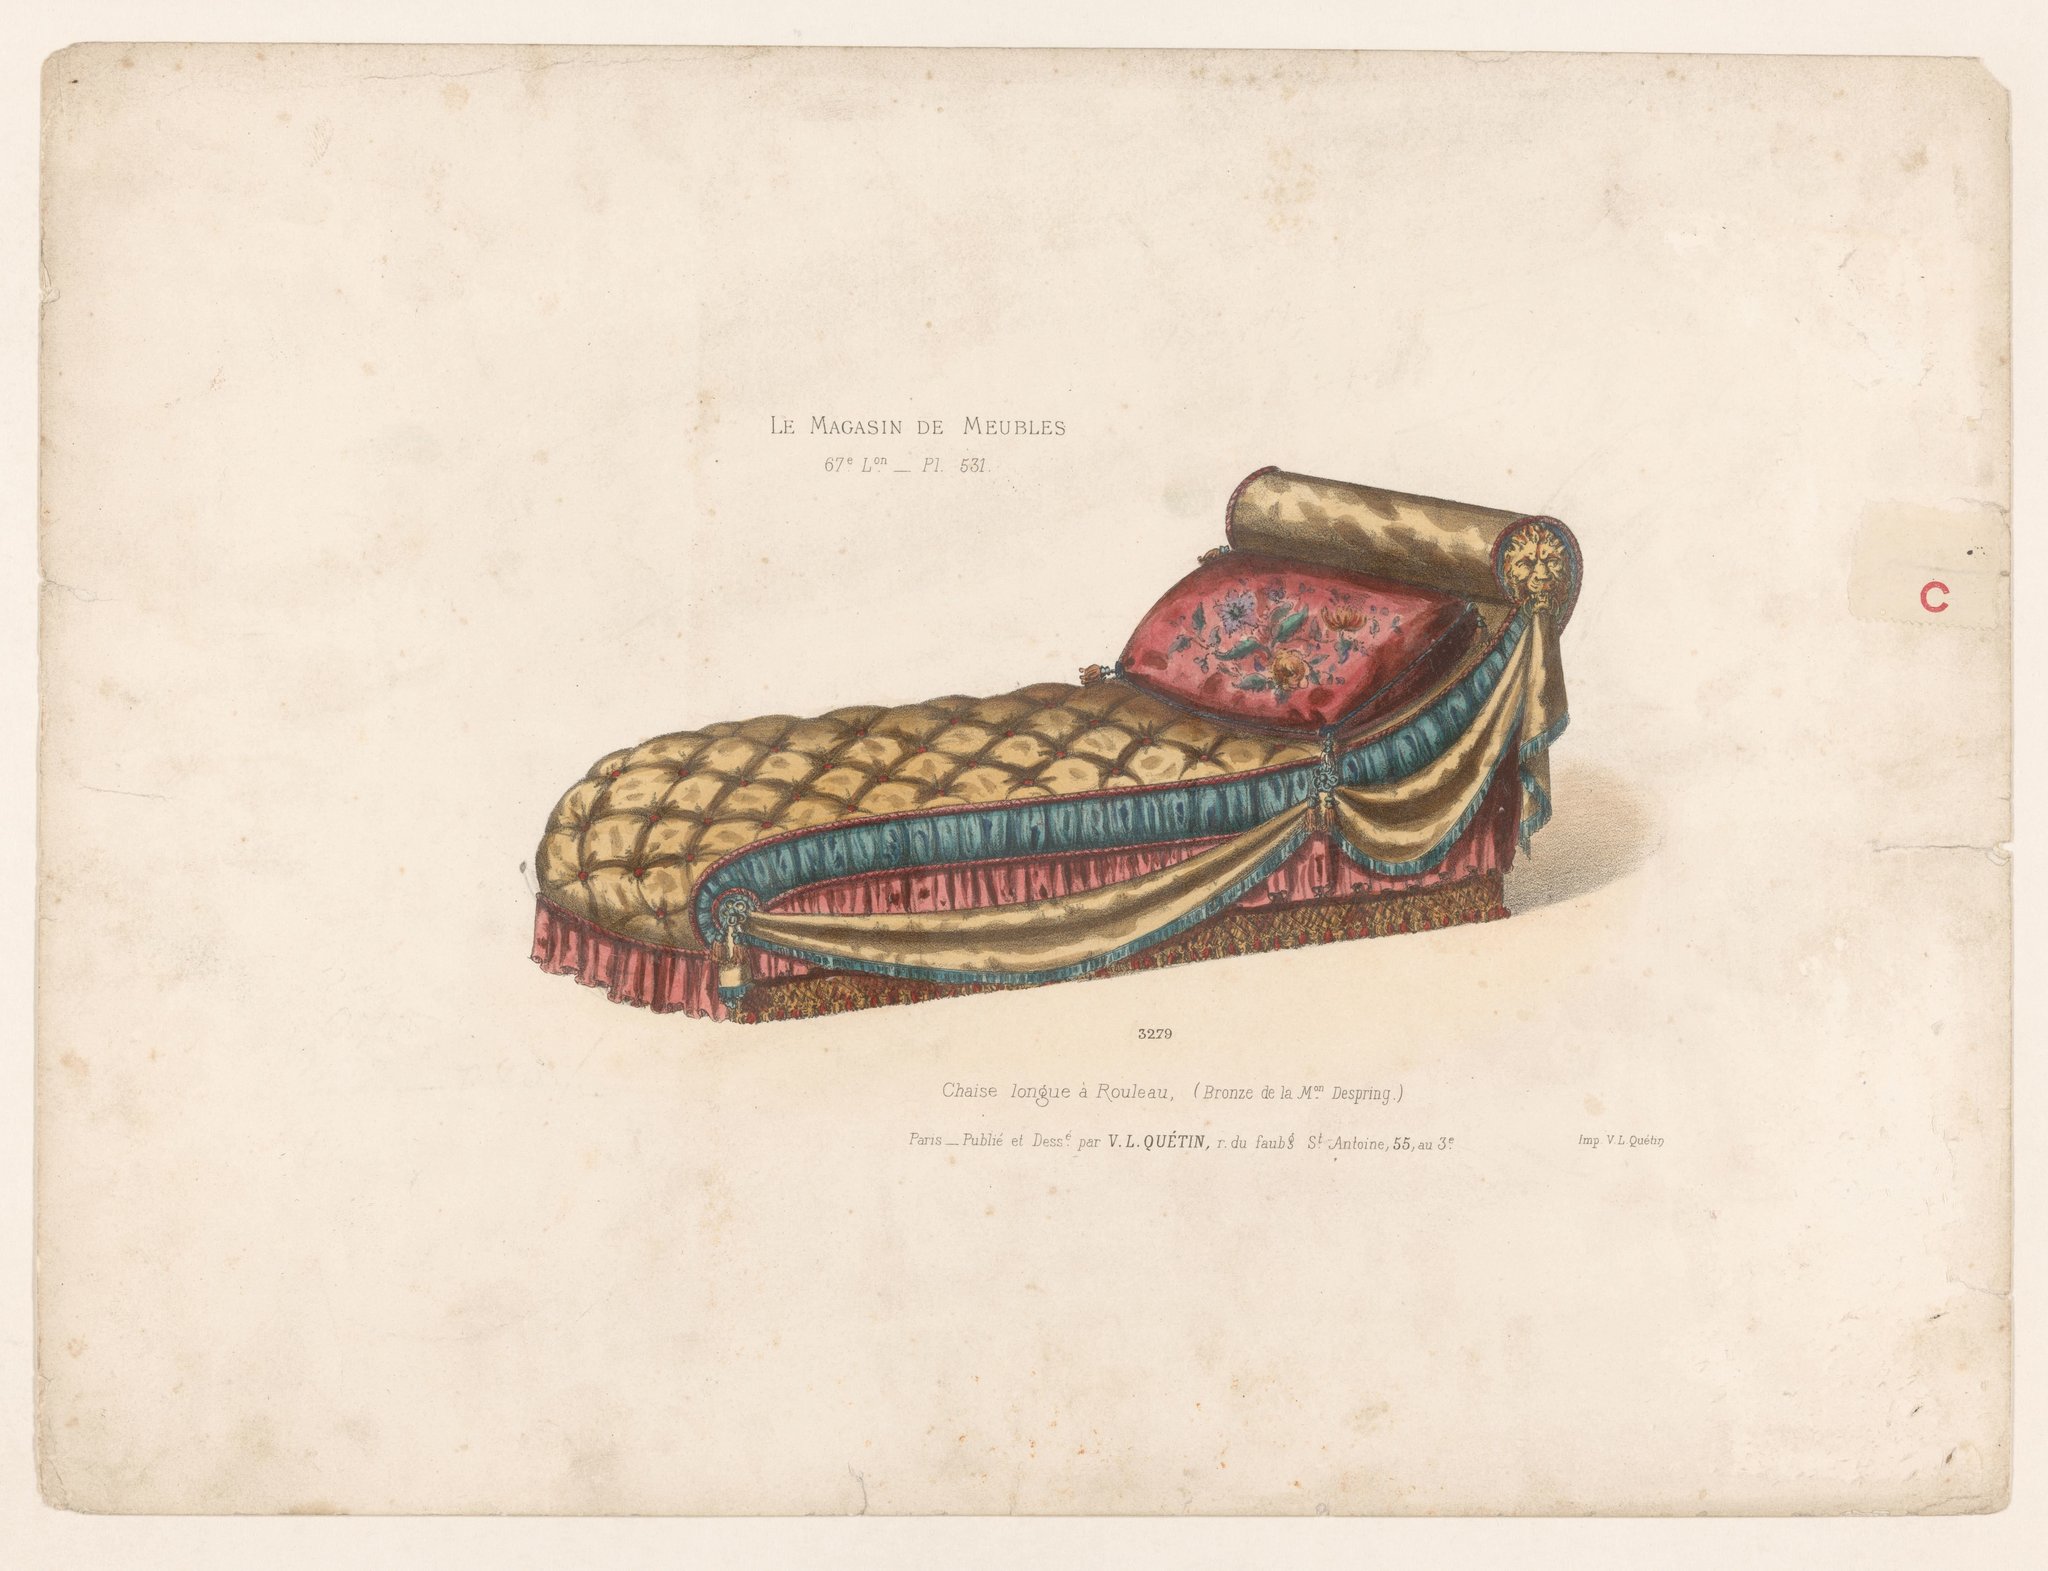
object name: print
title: Le Magasin de Meubles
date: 1878-1904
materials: paper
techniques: hand coloring, lithograph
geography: paris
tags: seating furniture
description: Een chaise longue. Prent uit 67e Livraison.